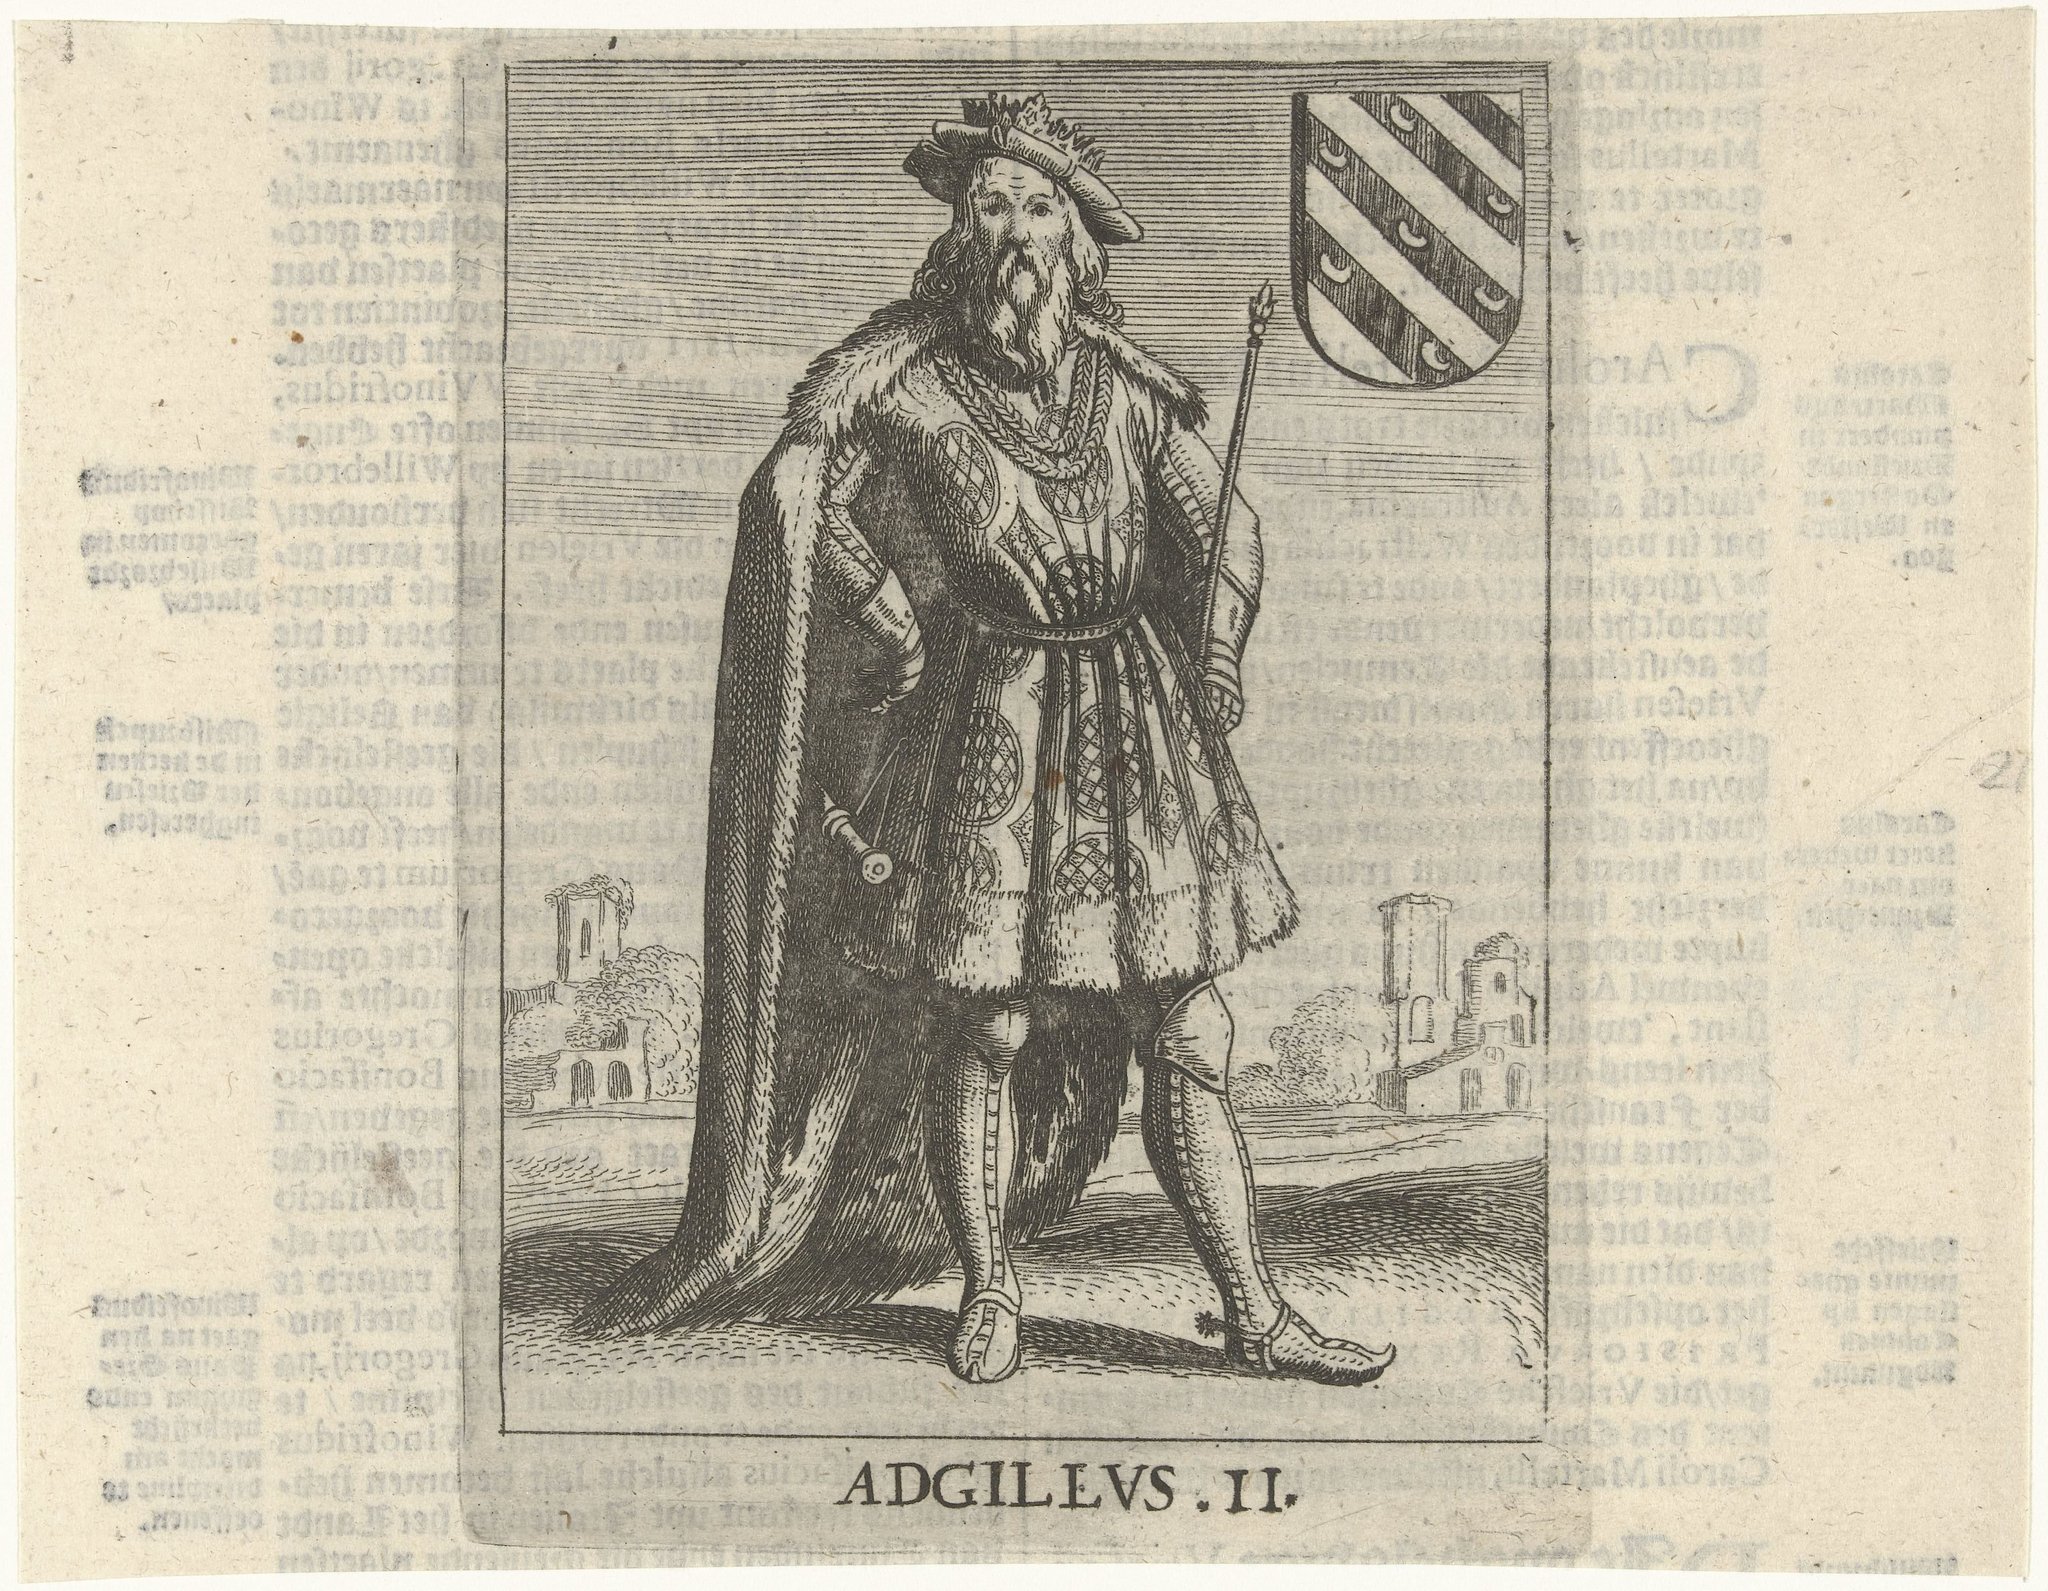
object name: print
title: Adgillis II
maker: jan lamrinck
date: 1622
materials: paper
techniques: etching, letterpress printing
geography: franeker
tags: adgilt ii (koning der friezen)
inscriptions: collector's mark: Lugt 2228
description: De prent is ook als boekillustratie gebruikt in: Winsemius, P.W. Chronique ofte Historische geschiedenisse van Vrieslant (...). Franeker: Joannes Lamrinck, 1622.